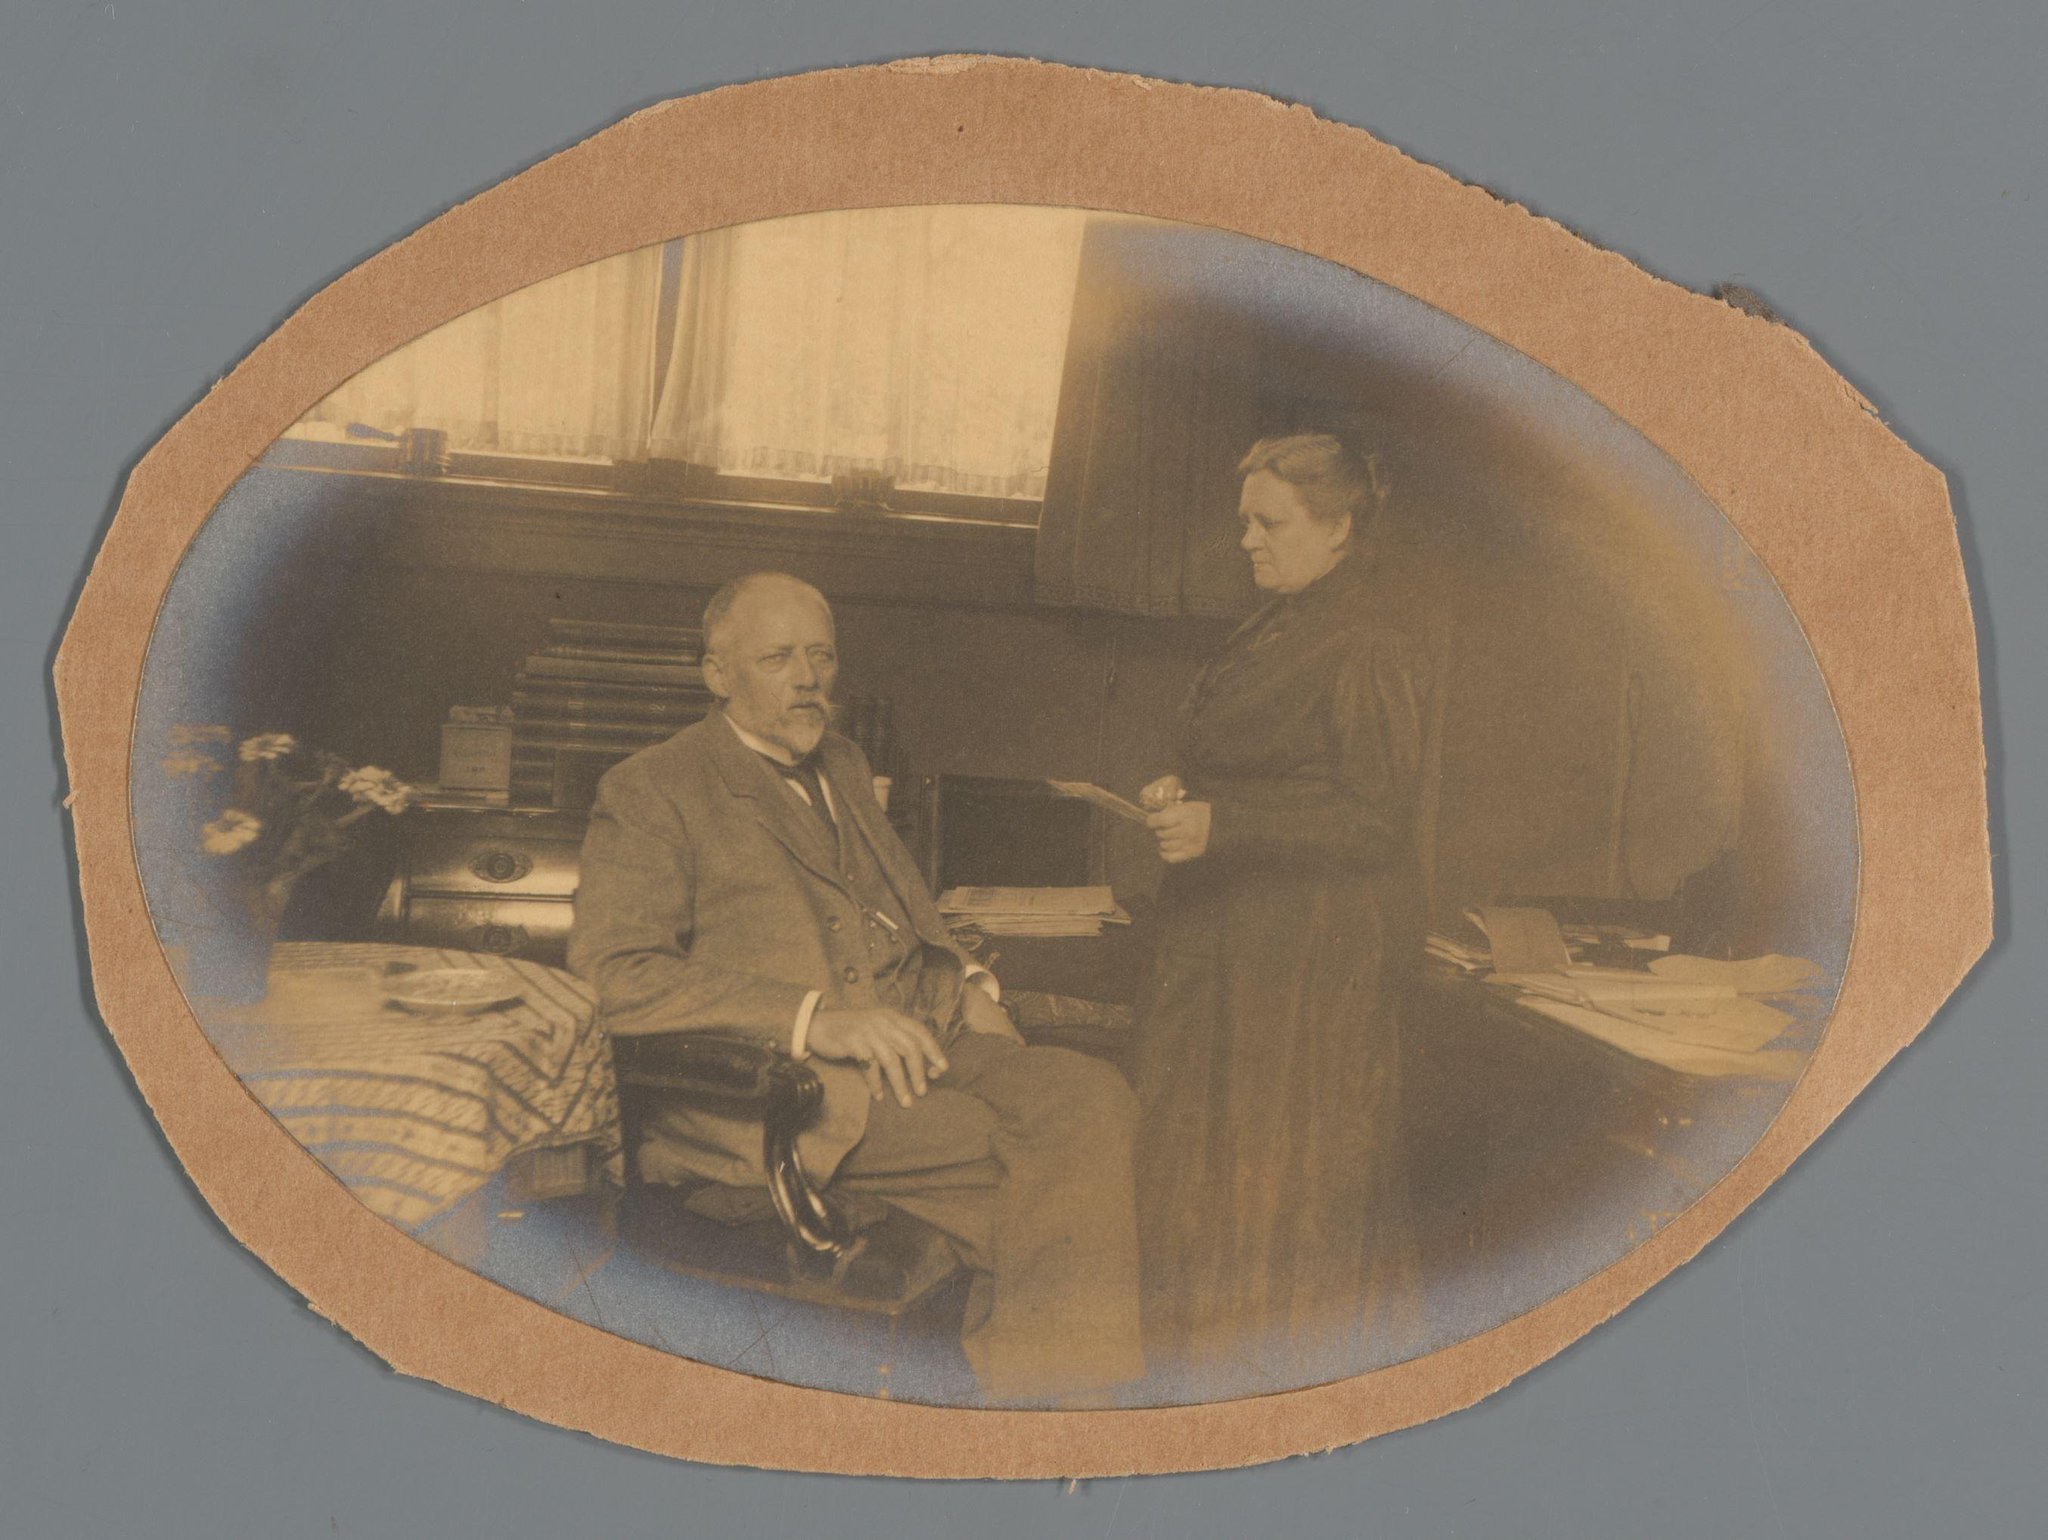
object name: photograph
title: Portret van Lucas Jonker en Neletta Jonker-van der Linden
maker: Anonymous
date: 1890-1915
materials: cardboard, photographic support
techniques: gelatin silver print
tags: haarlem, historical persons